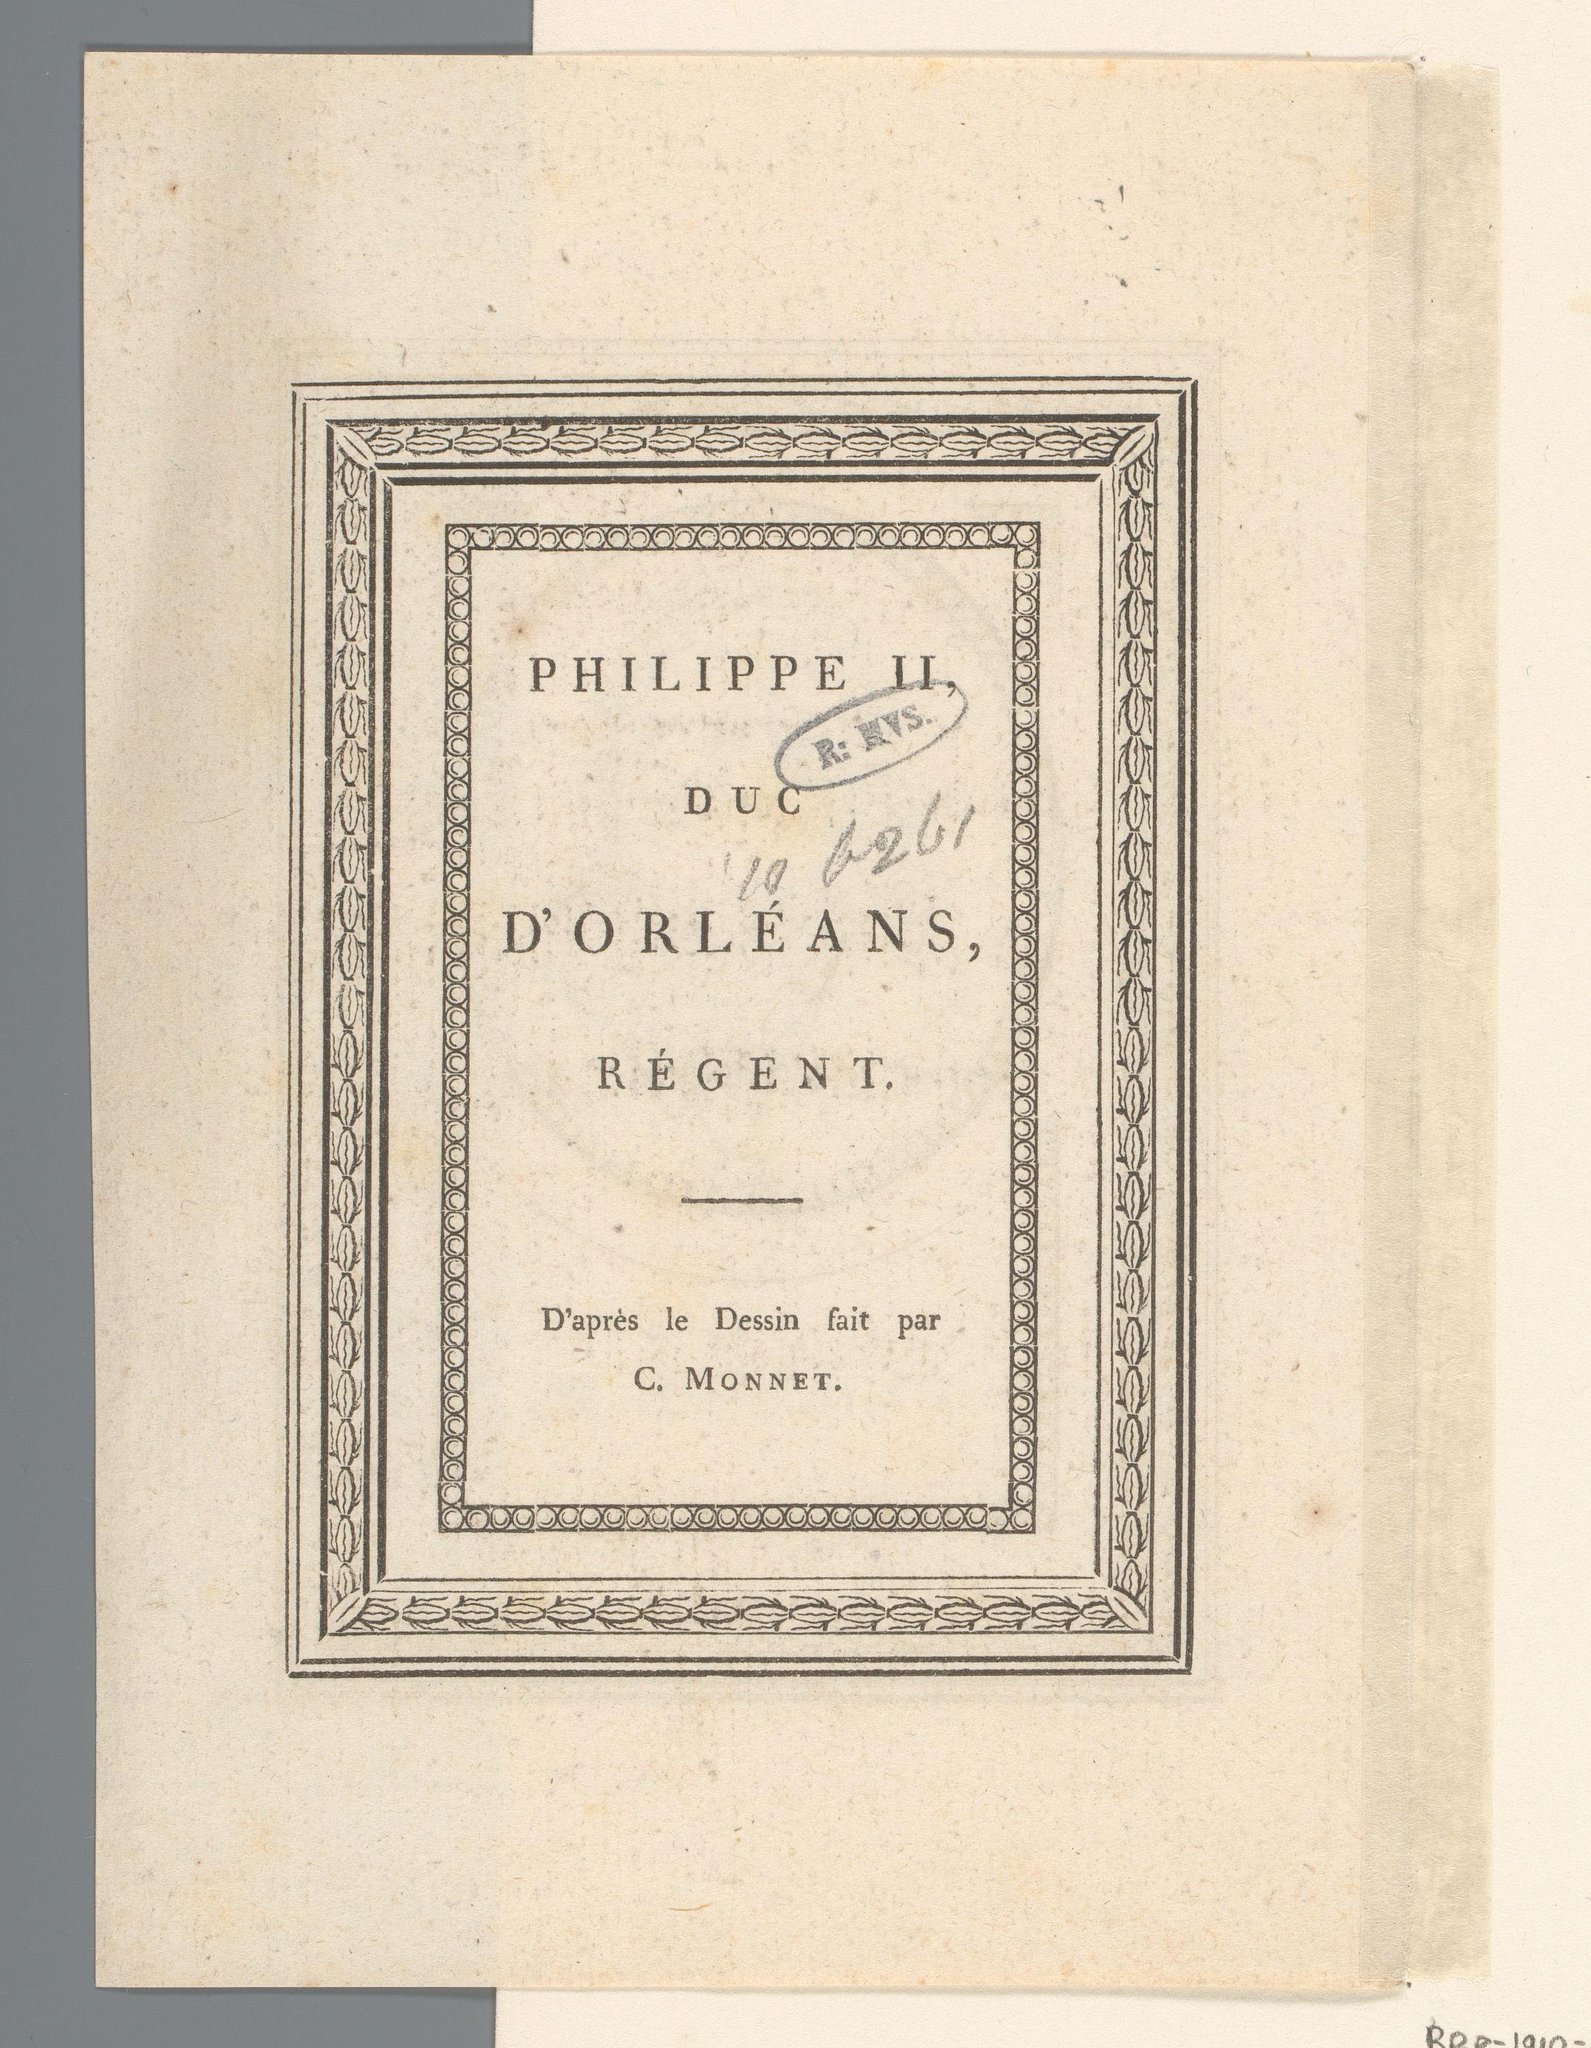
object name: print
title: Omlijsting met tekst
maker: Anonymous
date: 1700-1749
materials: paper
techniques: letterpress printing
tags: decoration of printed matter, historical persons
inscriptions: collector's mark: Lugt 2228